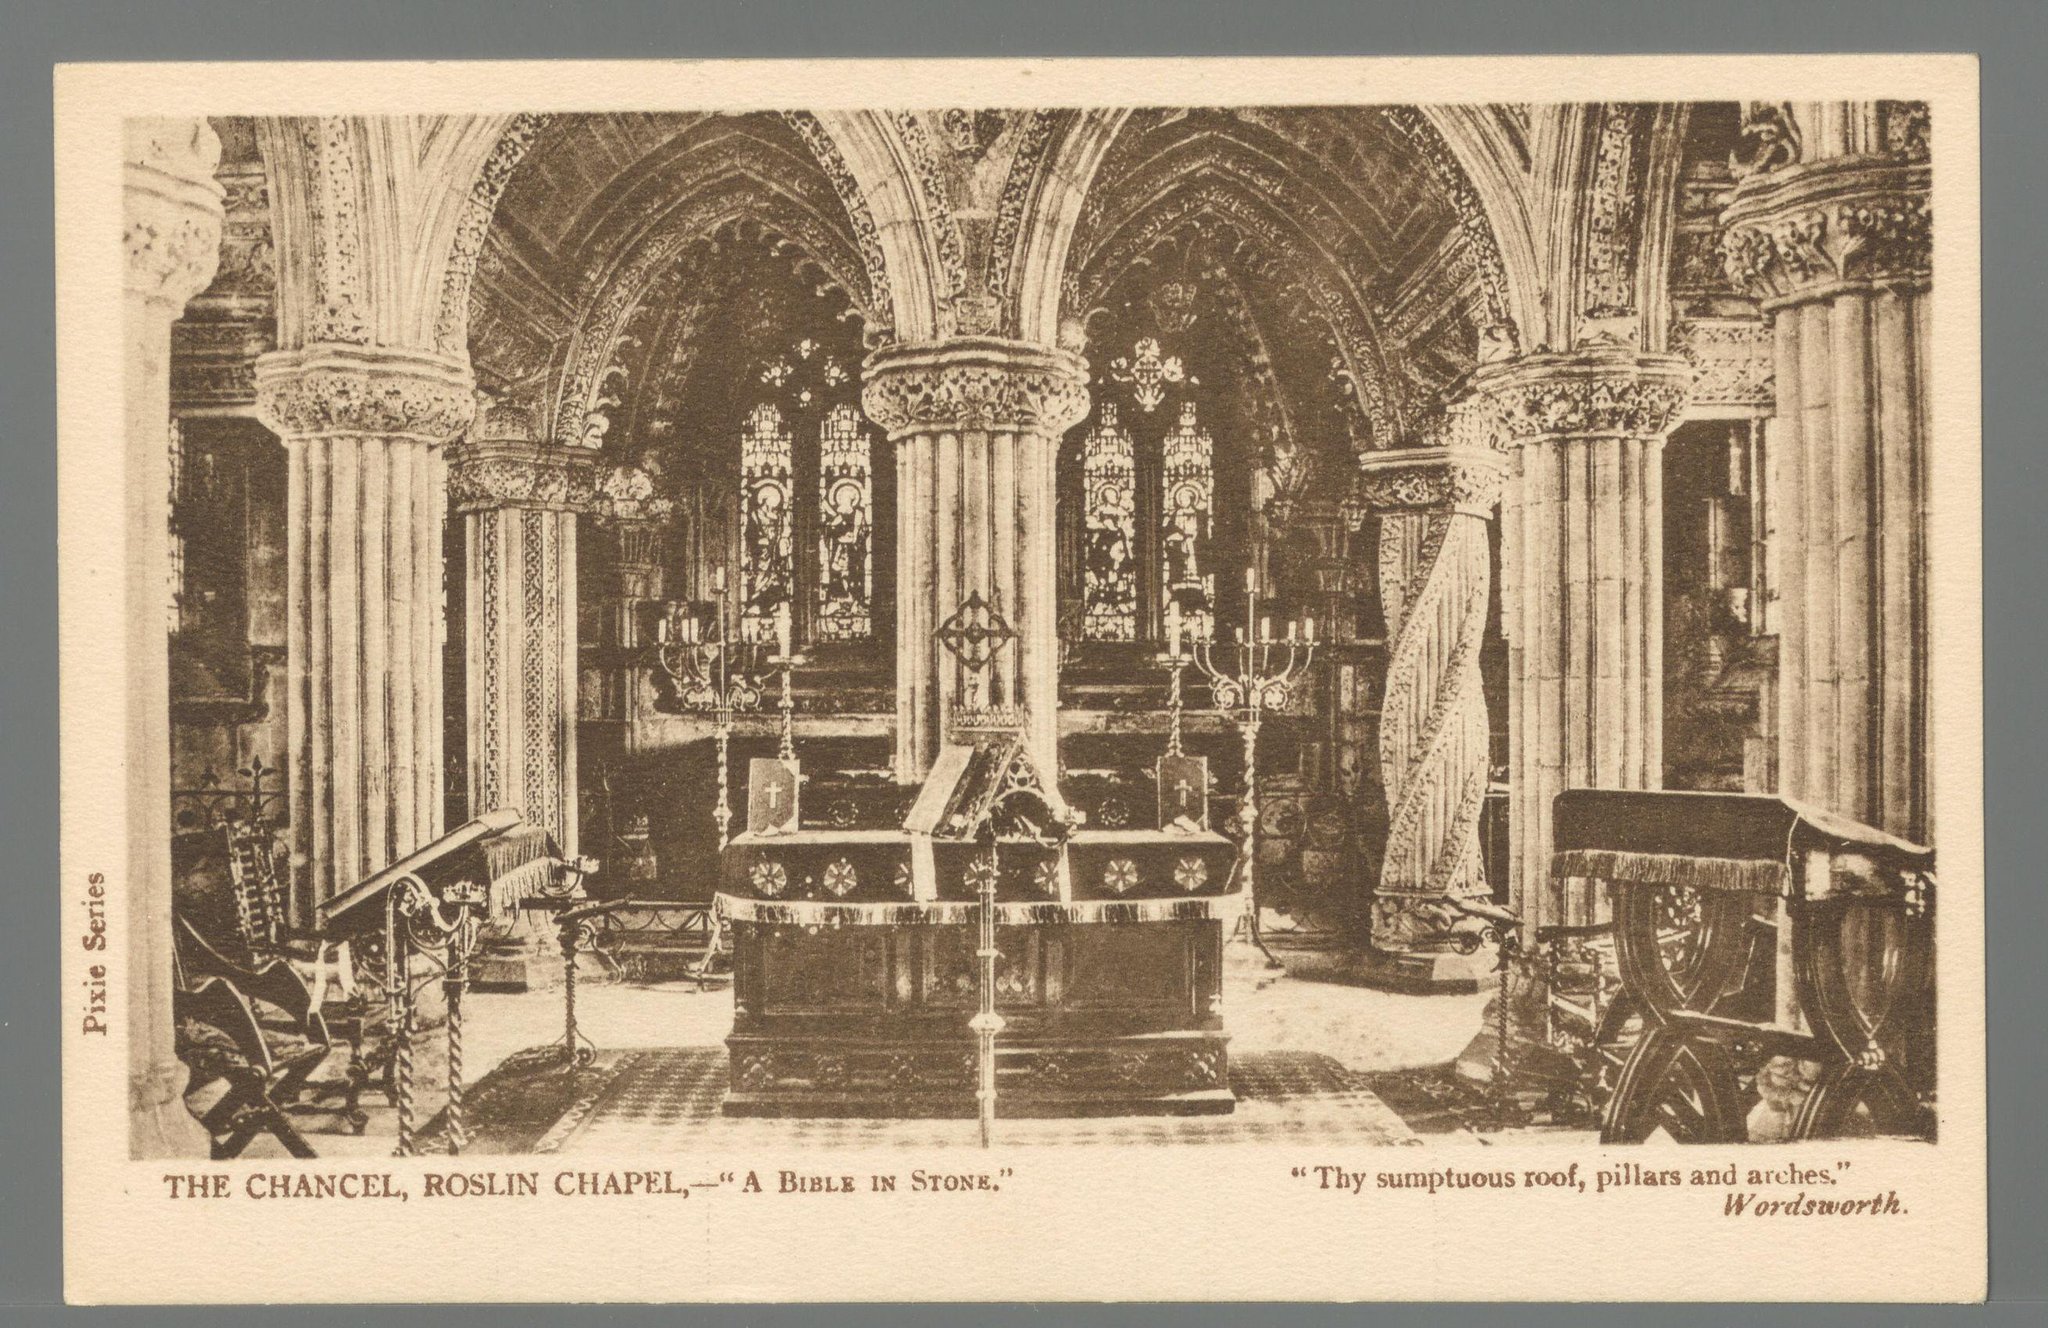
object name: ansichtkaart, prentbriefkaart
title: Pixie Series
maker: Anonymous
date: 1915-1930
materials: cardboard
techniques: photograph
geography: roslin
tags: parts of church exterior and annexes: chapel - qq - small church, chapel, pulpit, ambo, chancel